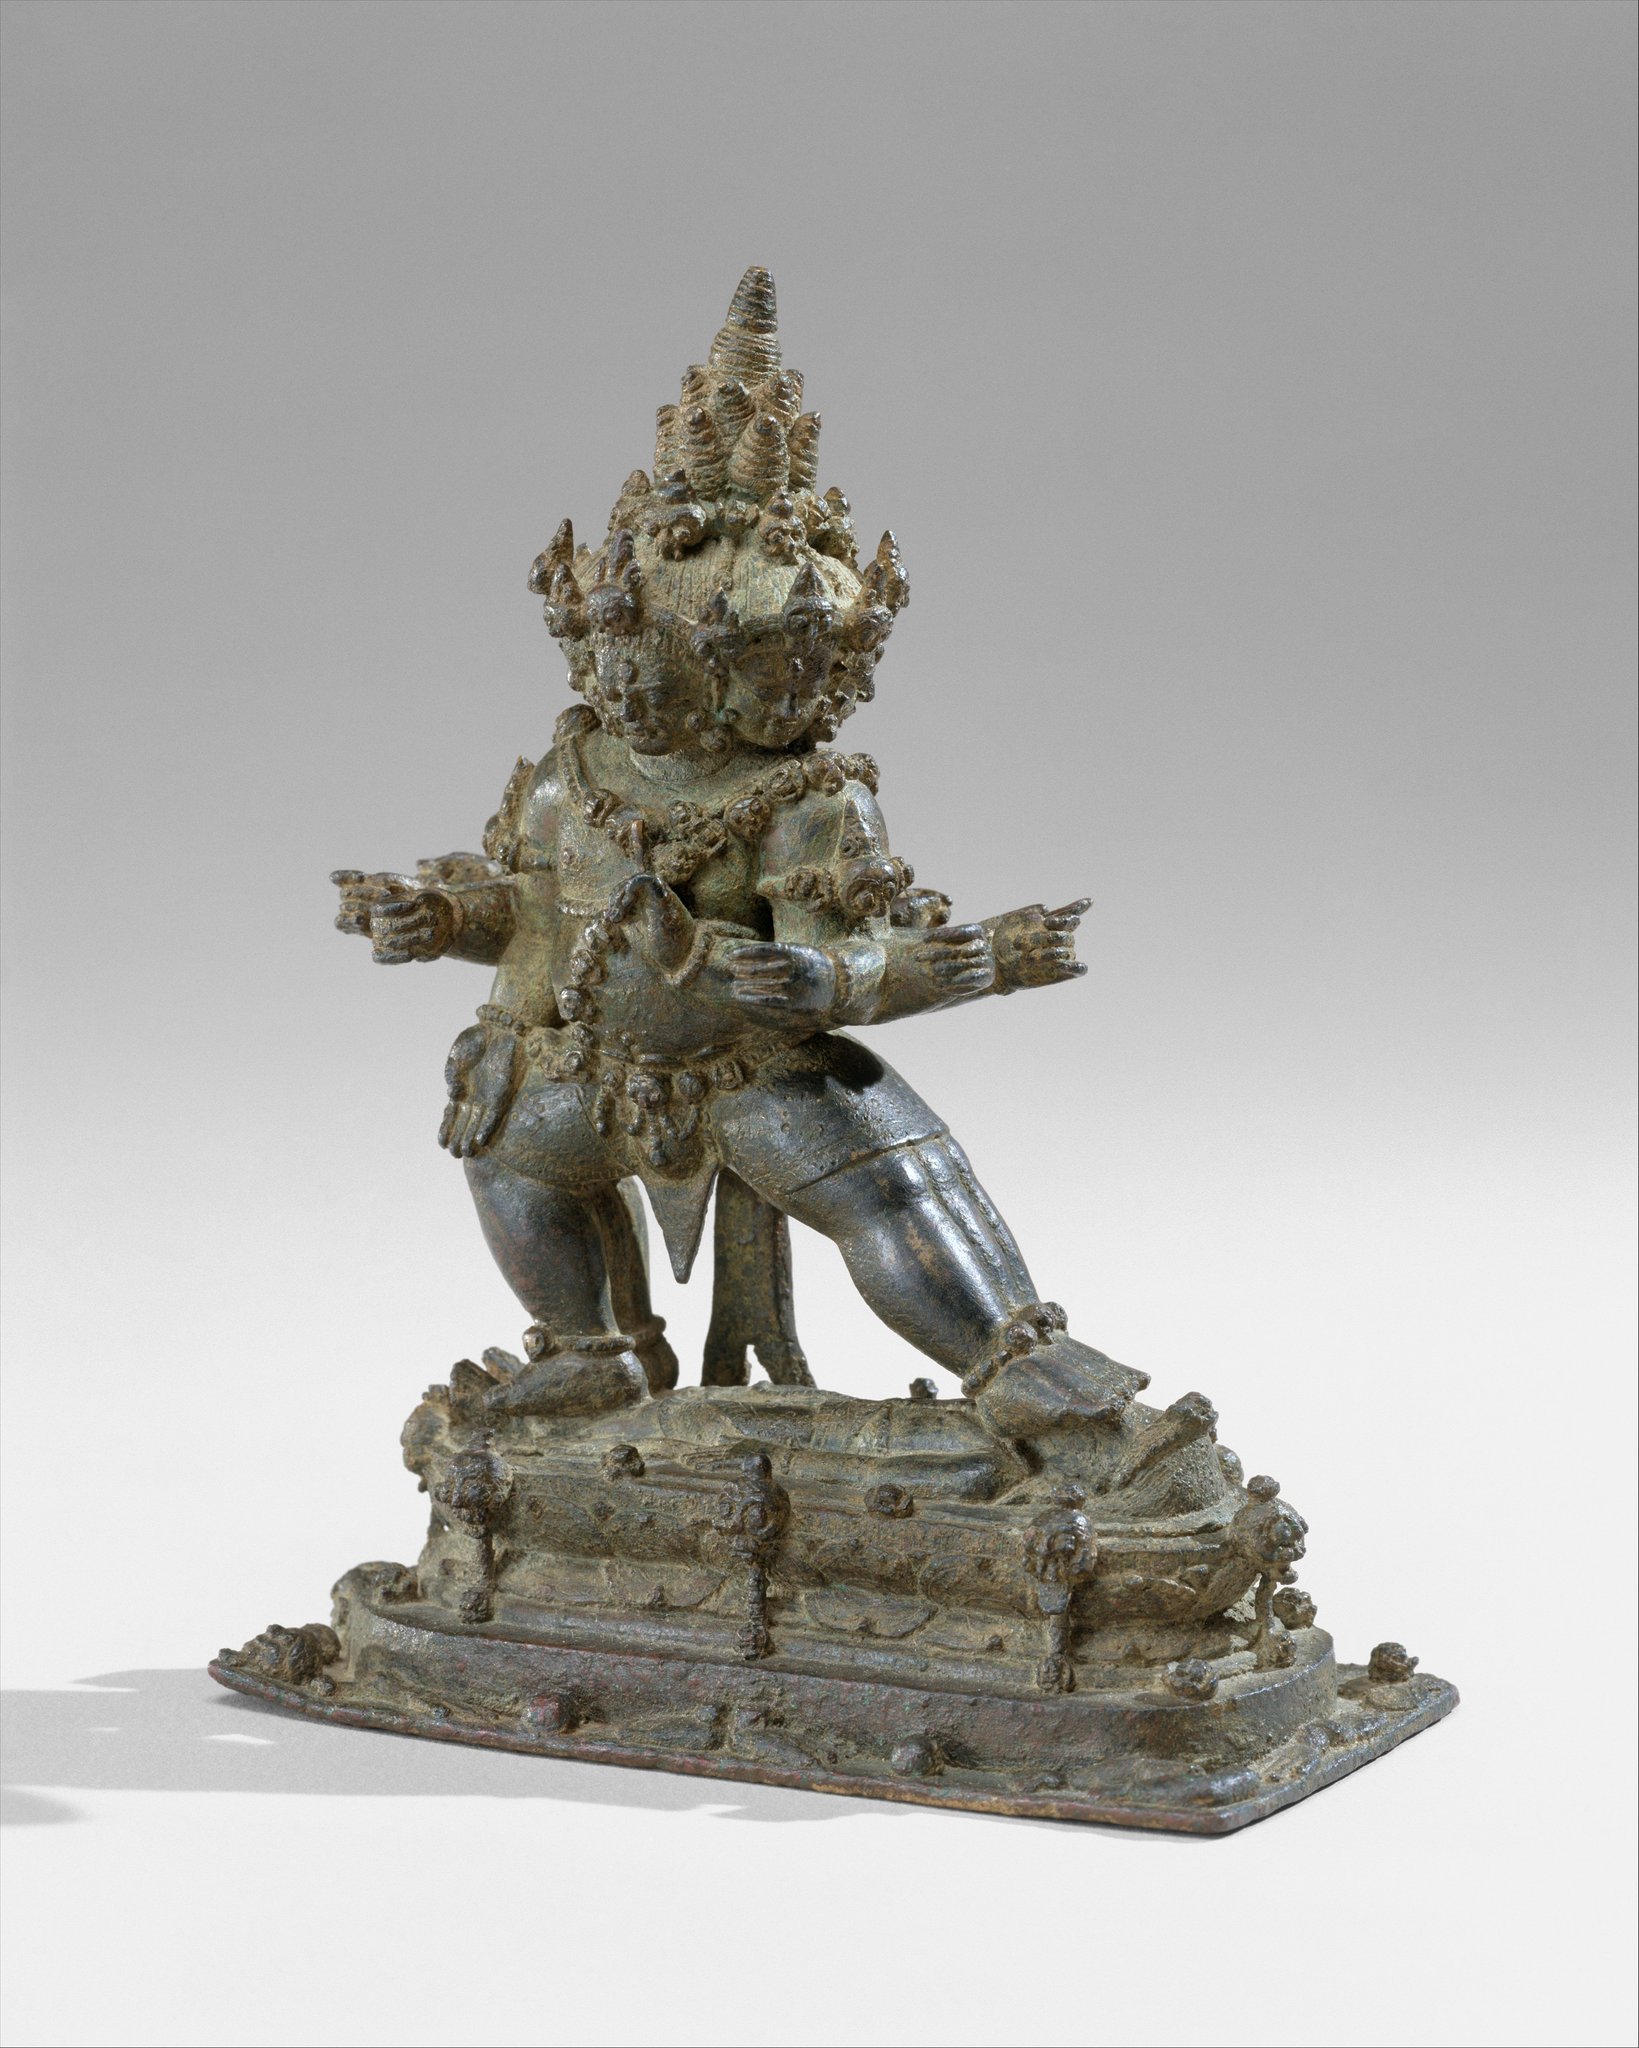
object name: figure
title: The Buddhist Guardian Mahabala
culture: indonesian, javanese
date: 1001-1100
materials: bronze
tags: buddhism,deities